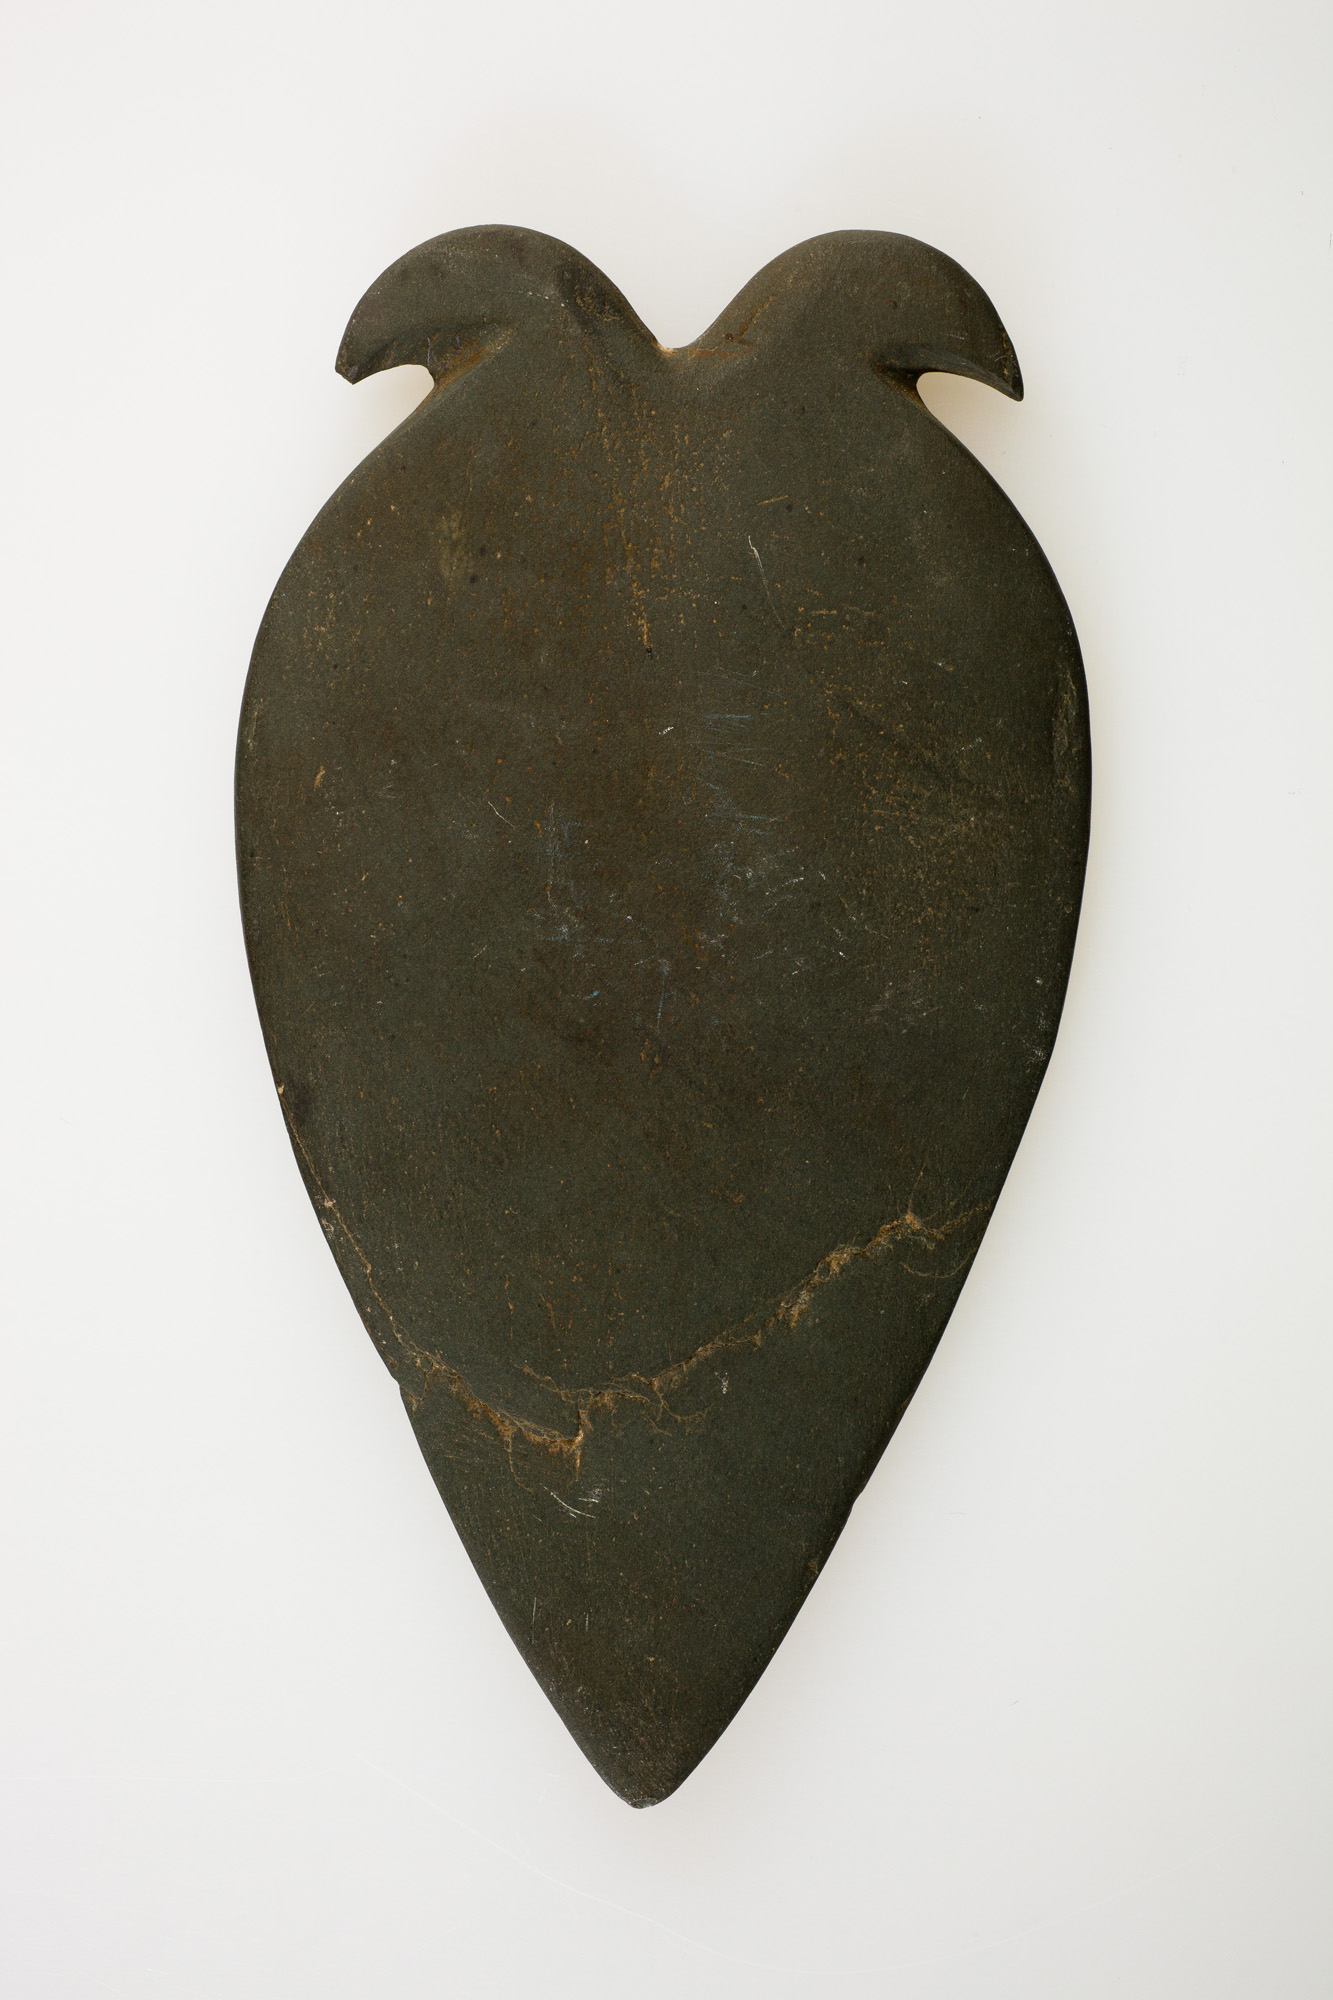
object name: palette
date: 3850-2960 BCE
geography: egypt